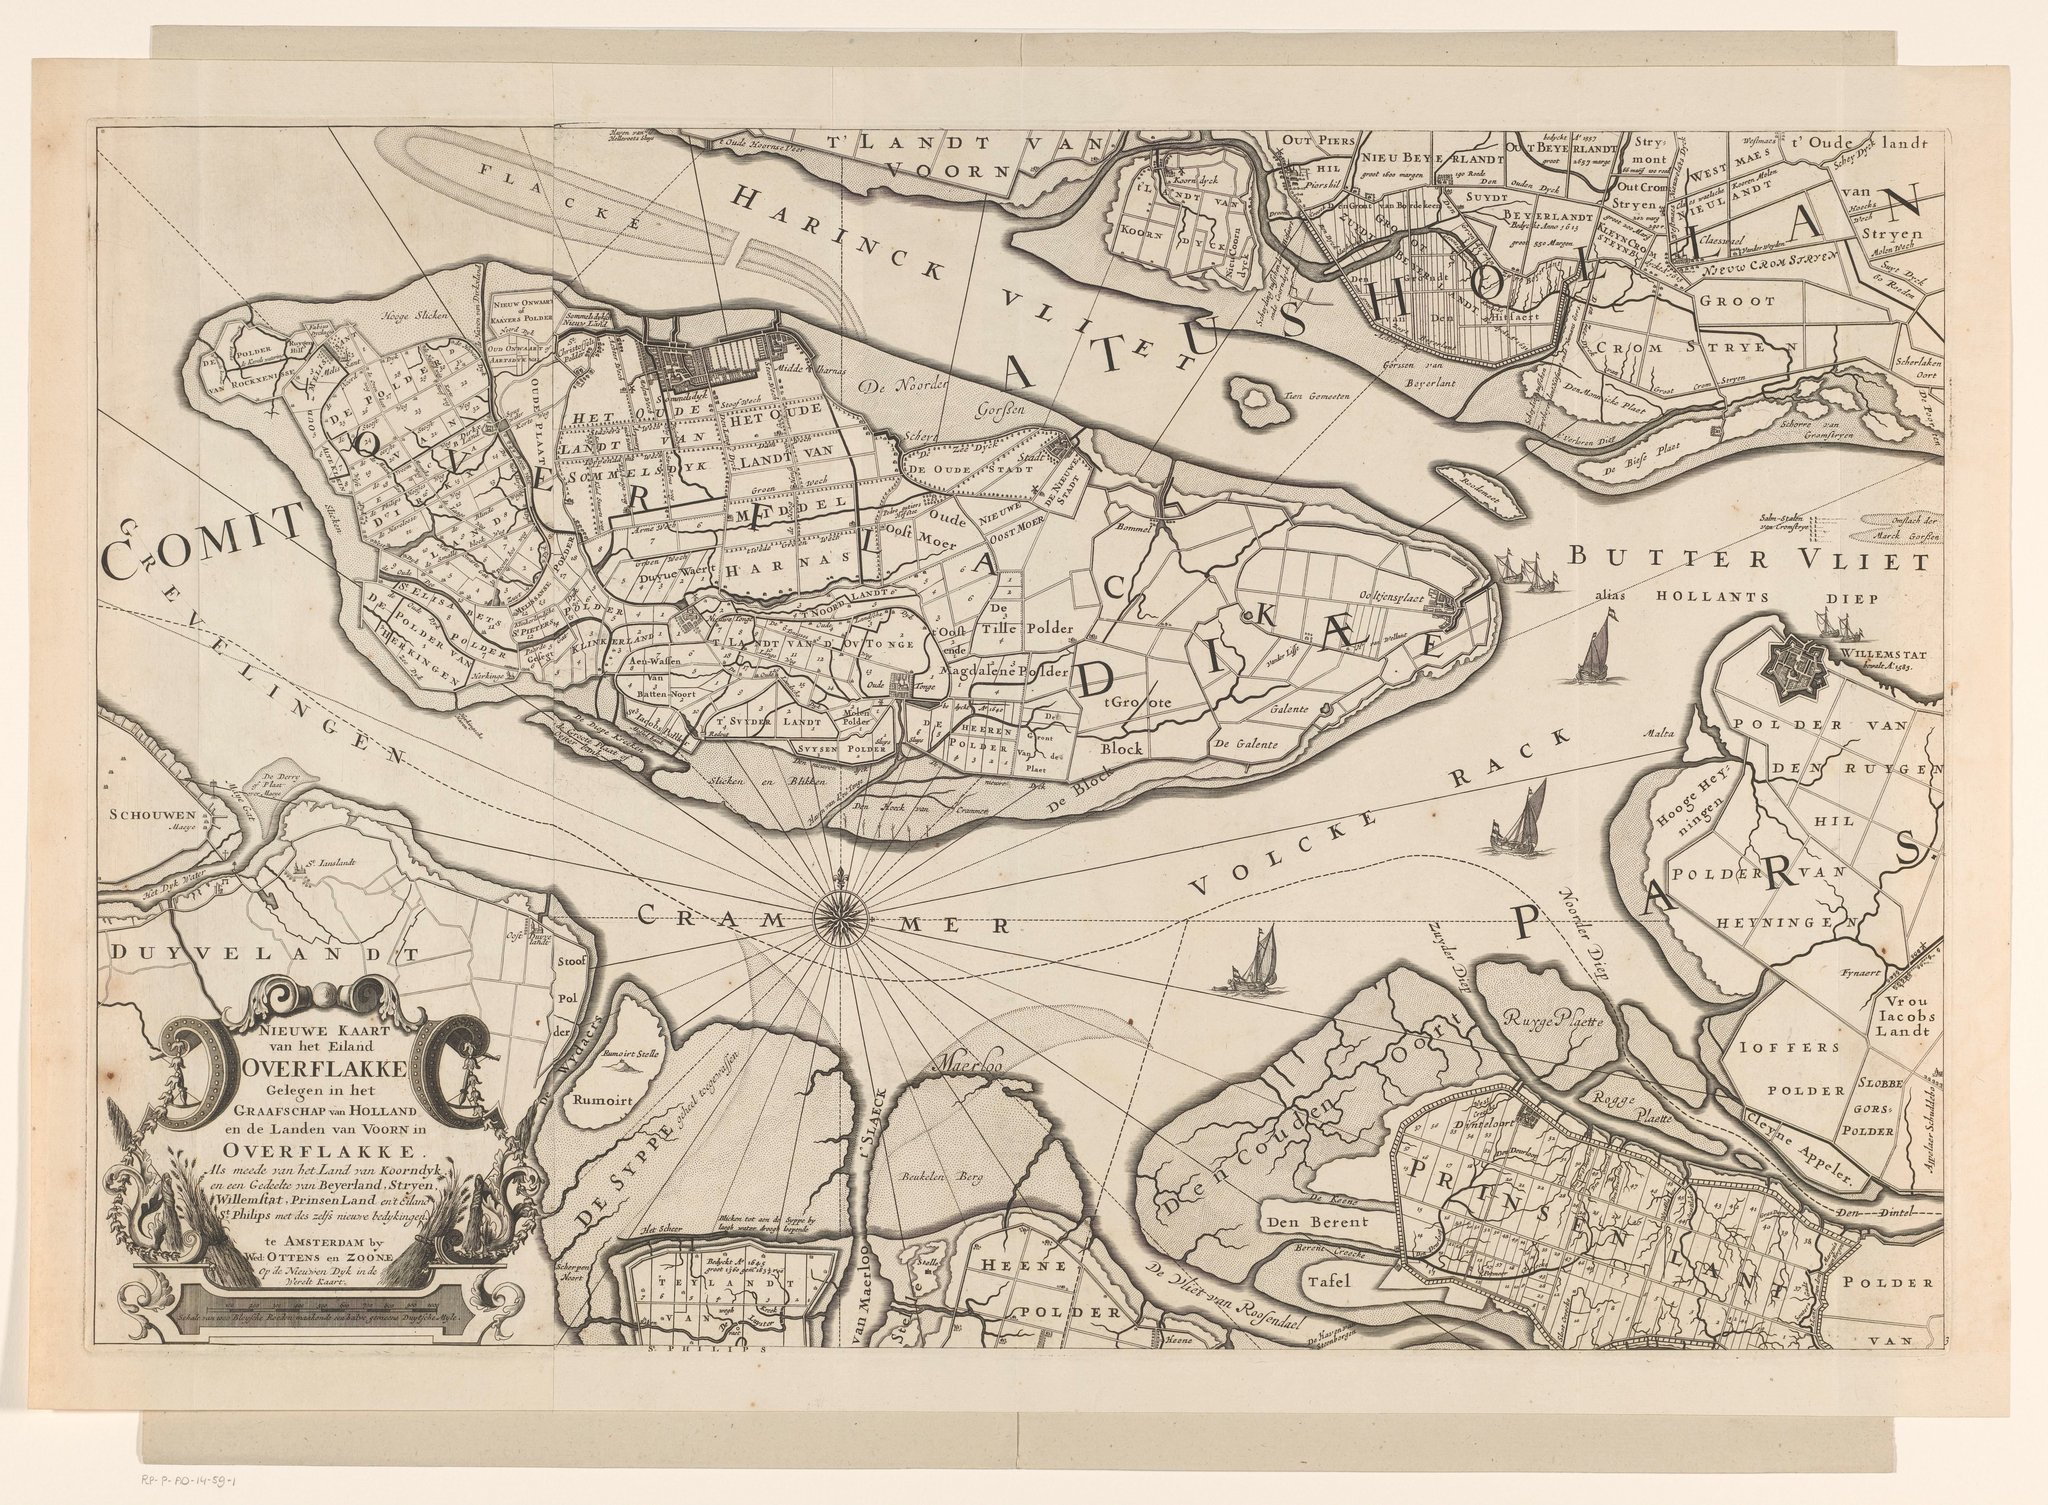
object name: map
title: Nieuwe Kaart van het Eiland Overflakke Gelegen in het Graafschap van Holland en de Landen van Voorn in Overflakke. Als meede van het Land van Koorndyk, en een Gedeelte van Beyerland, Stryen, Willemstat, Prinsenland en 't Eiland St. Philips met des zelfs nieuwe bedykingen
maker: Anonymous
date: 1655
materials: paper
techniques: engraving, etching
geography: amsterdam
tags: maps of separate countries or regions, zeeland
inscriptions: collector's mark: Lugt 195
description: Kaart van het eiland Overflakkee en de omliggende Zuid-Hollandse en Zeeuwse gebieden. Linksonder een cartouche met de titel en een schaalstok: Schale van 1000 Bloysche roeden maakende een halve gemeene Duytsche myle. Rechtsonder genummerd: 3.